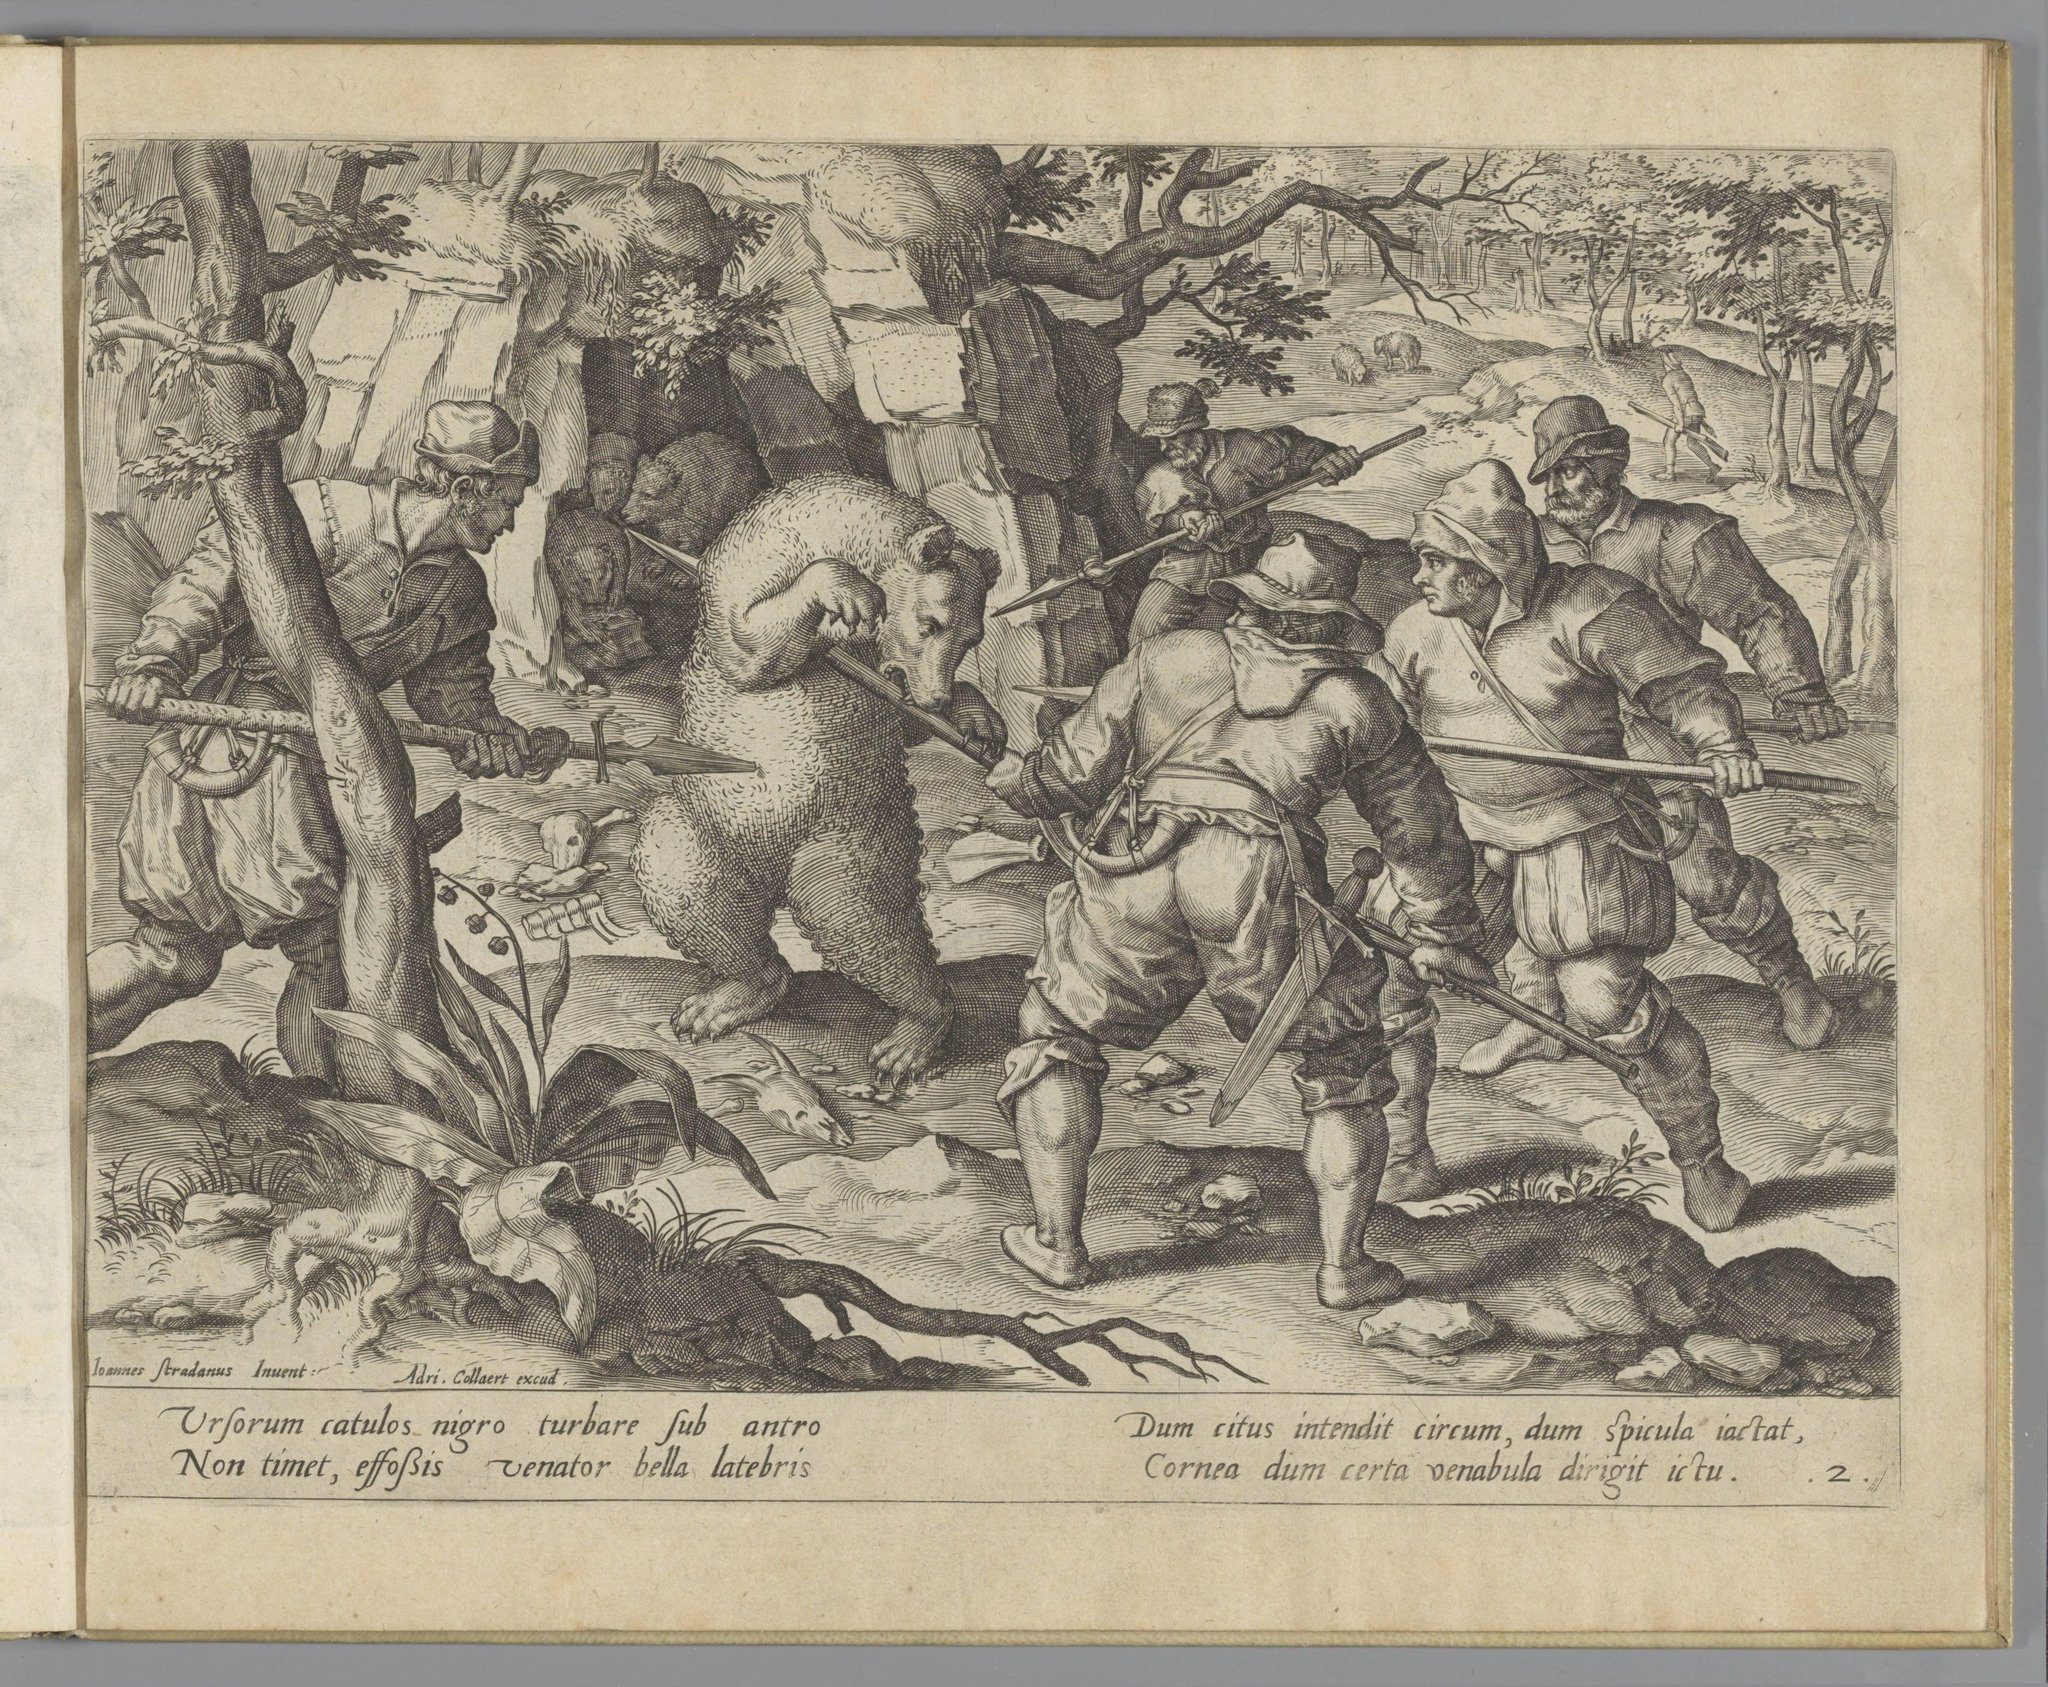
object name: print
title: Staande beer gedood door jagers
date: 1574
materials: paper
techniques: engraving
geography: antwerp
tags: casting weapons: spear, beasts of prey, predatory animals: bear, cave, grotto, hunt ~ mammals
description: Een staande beer wordt met speren doorstoken door vijf jagers. Op de achtergrond een grot met drie beren. Onder de voorstelling een vierregelig vers in het Latijn. Deze prent maakt deel uit van een album.